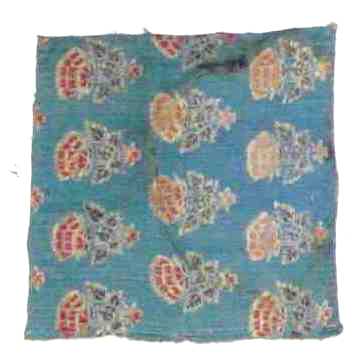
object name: textile fragment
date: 1667-1700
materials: metal thread, silk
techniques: brocade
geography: iran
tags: flowers